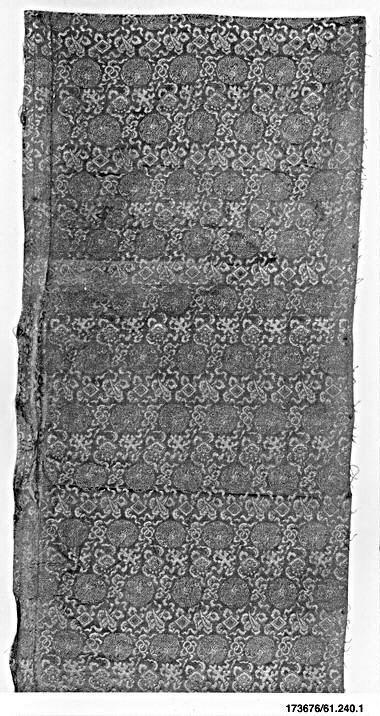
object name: piece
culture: chinese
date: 1601-1700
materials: metal thread, silk